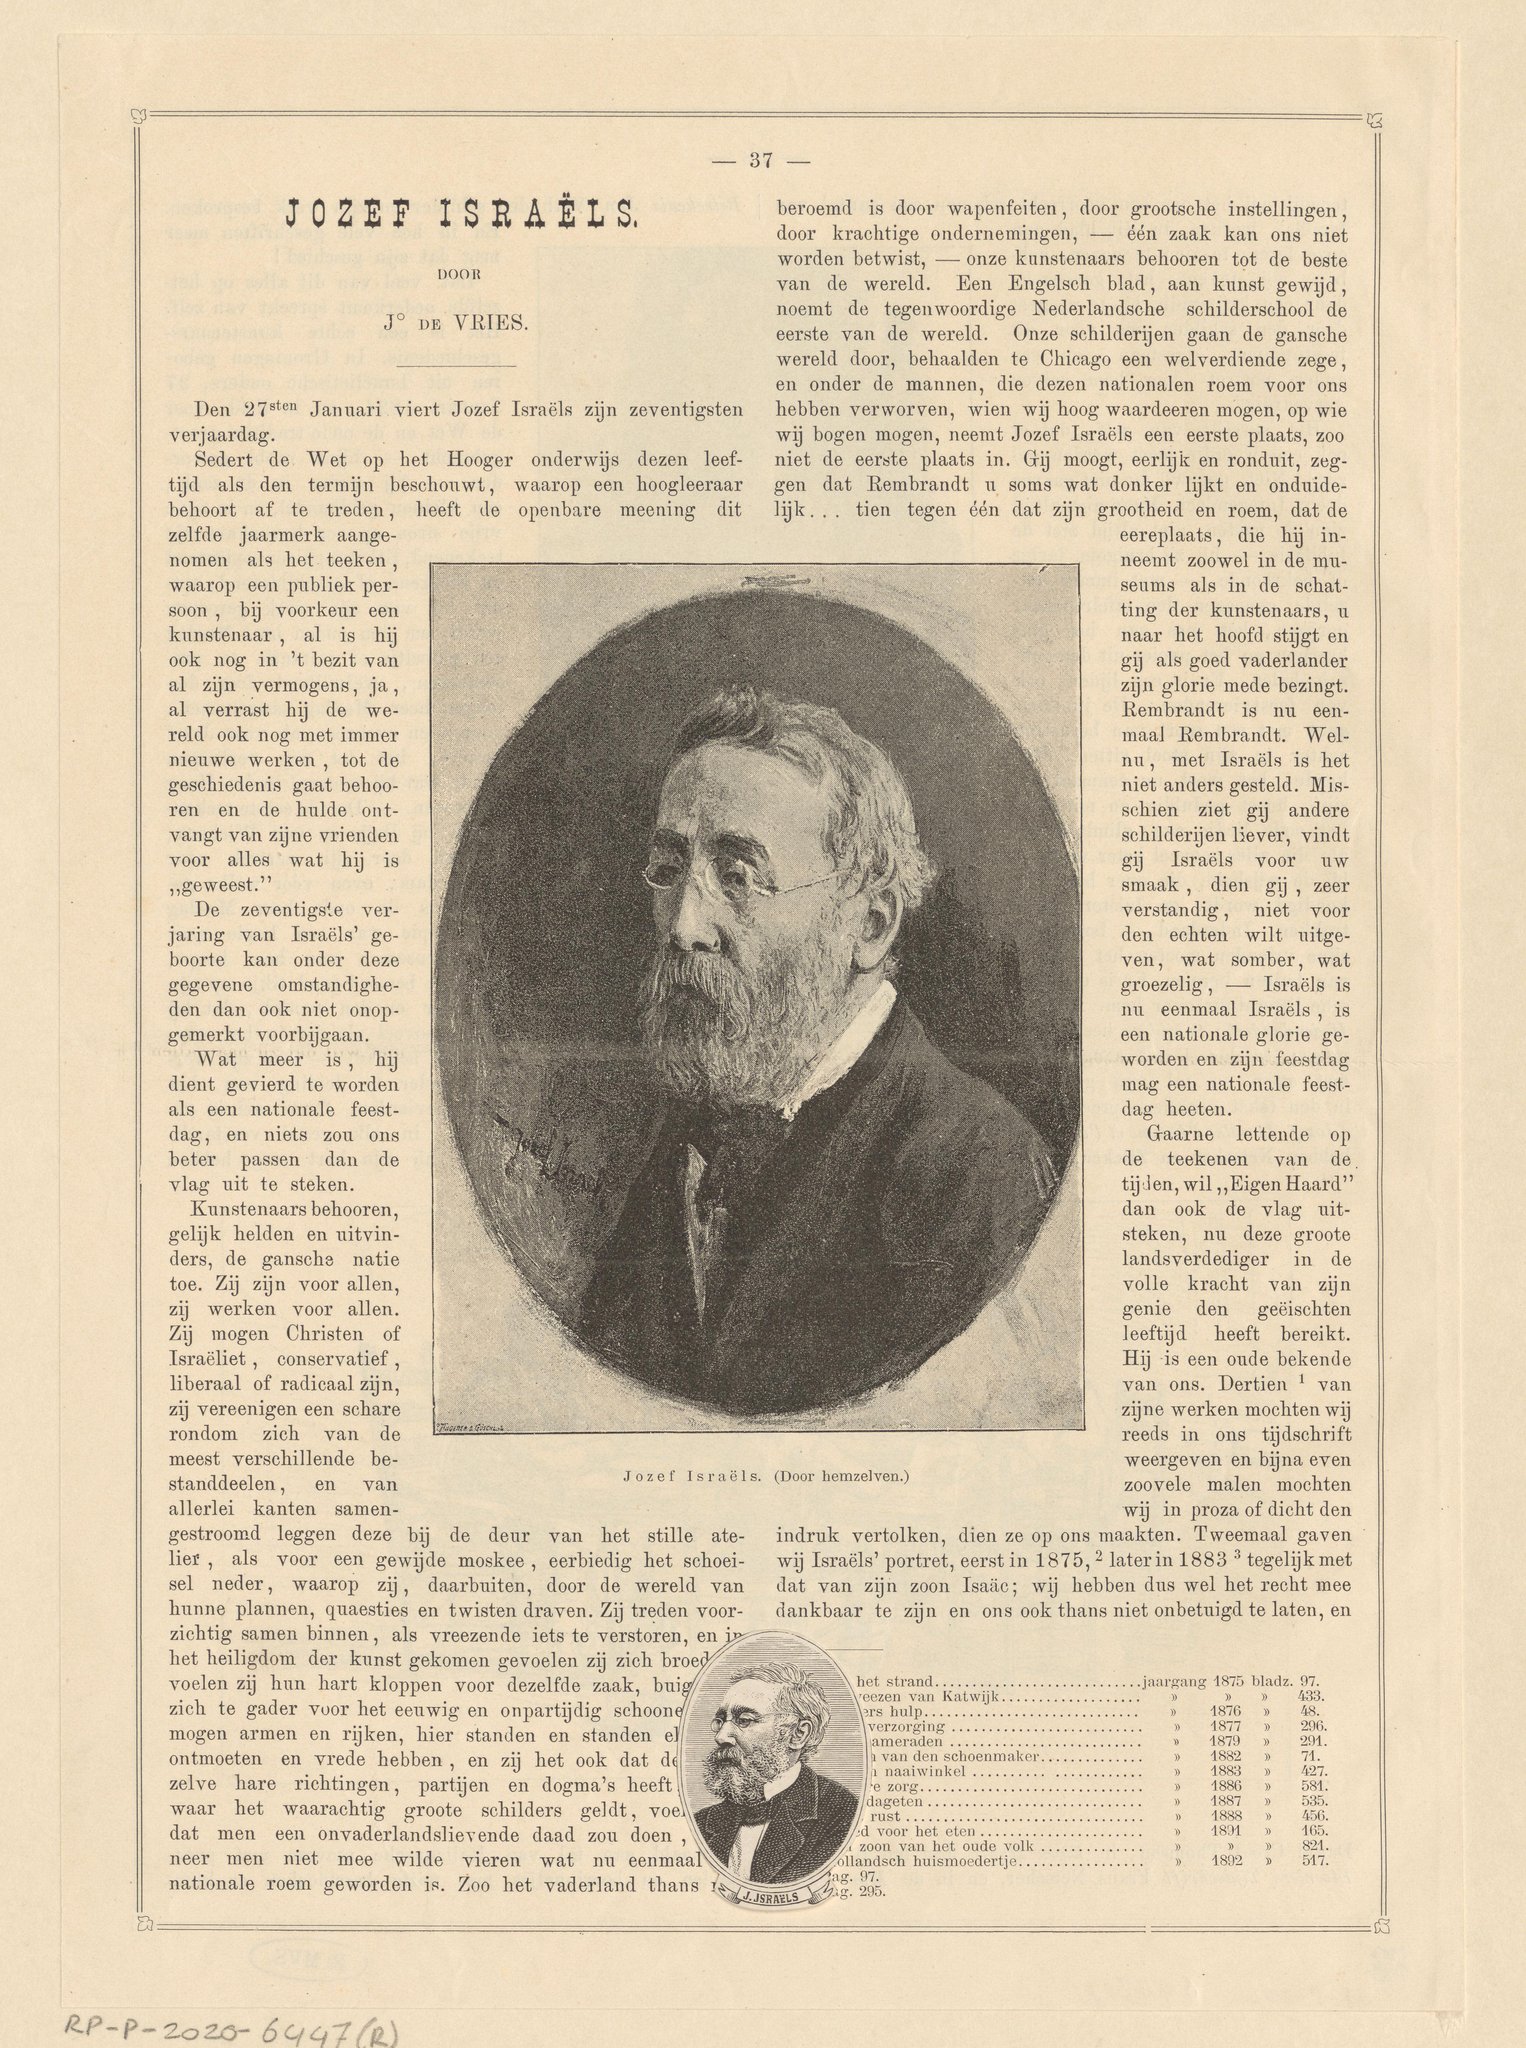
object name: print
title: Twee portretten van Jozef Israëls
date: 1894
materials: paper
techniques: letterpress printing, engraving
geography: haarlem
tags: the hague, painter, print maker, draughtsman, jozef israëls, historical persons, portrait, self-portrait of painter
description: Fotomechanische afdruk uit: Eigen haard, nr. 3, 1894, p. 37.